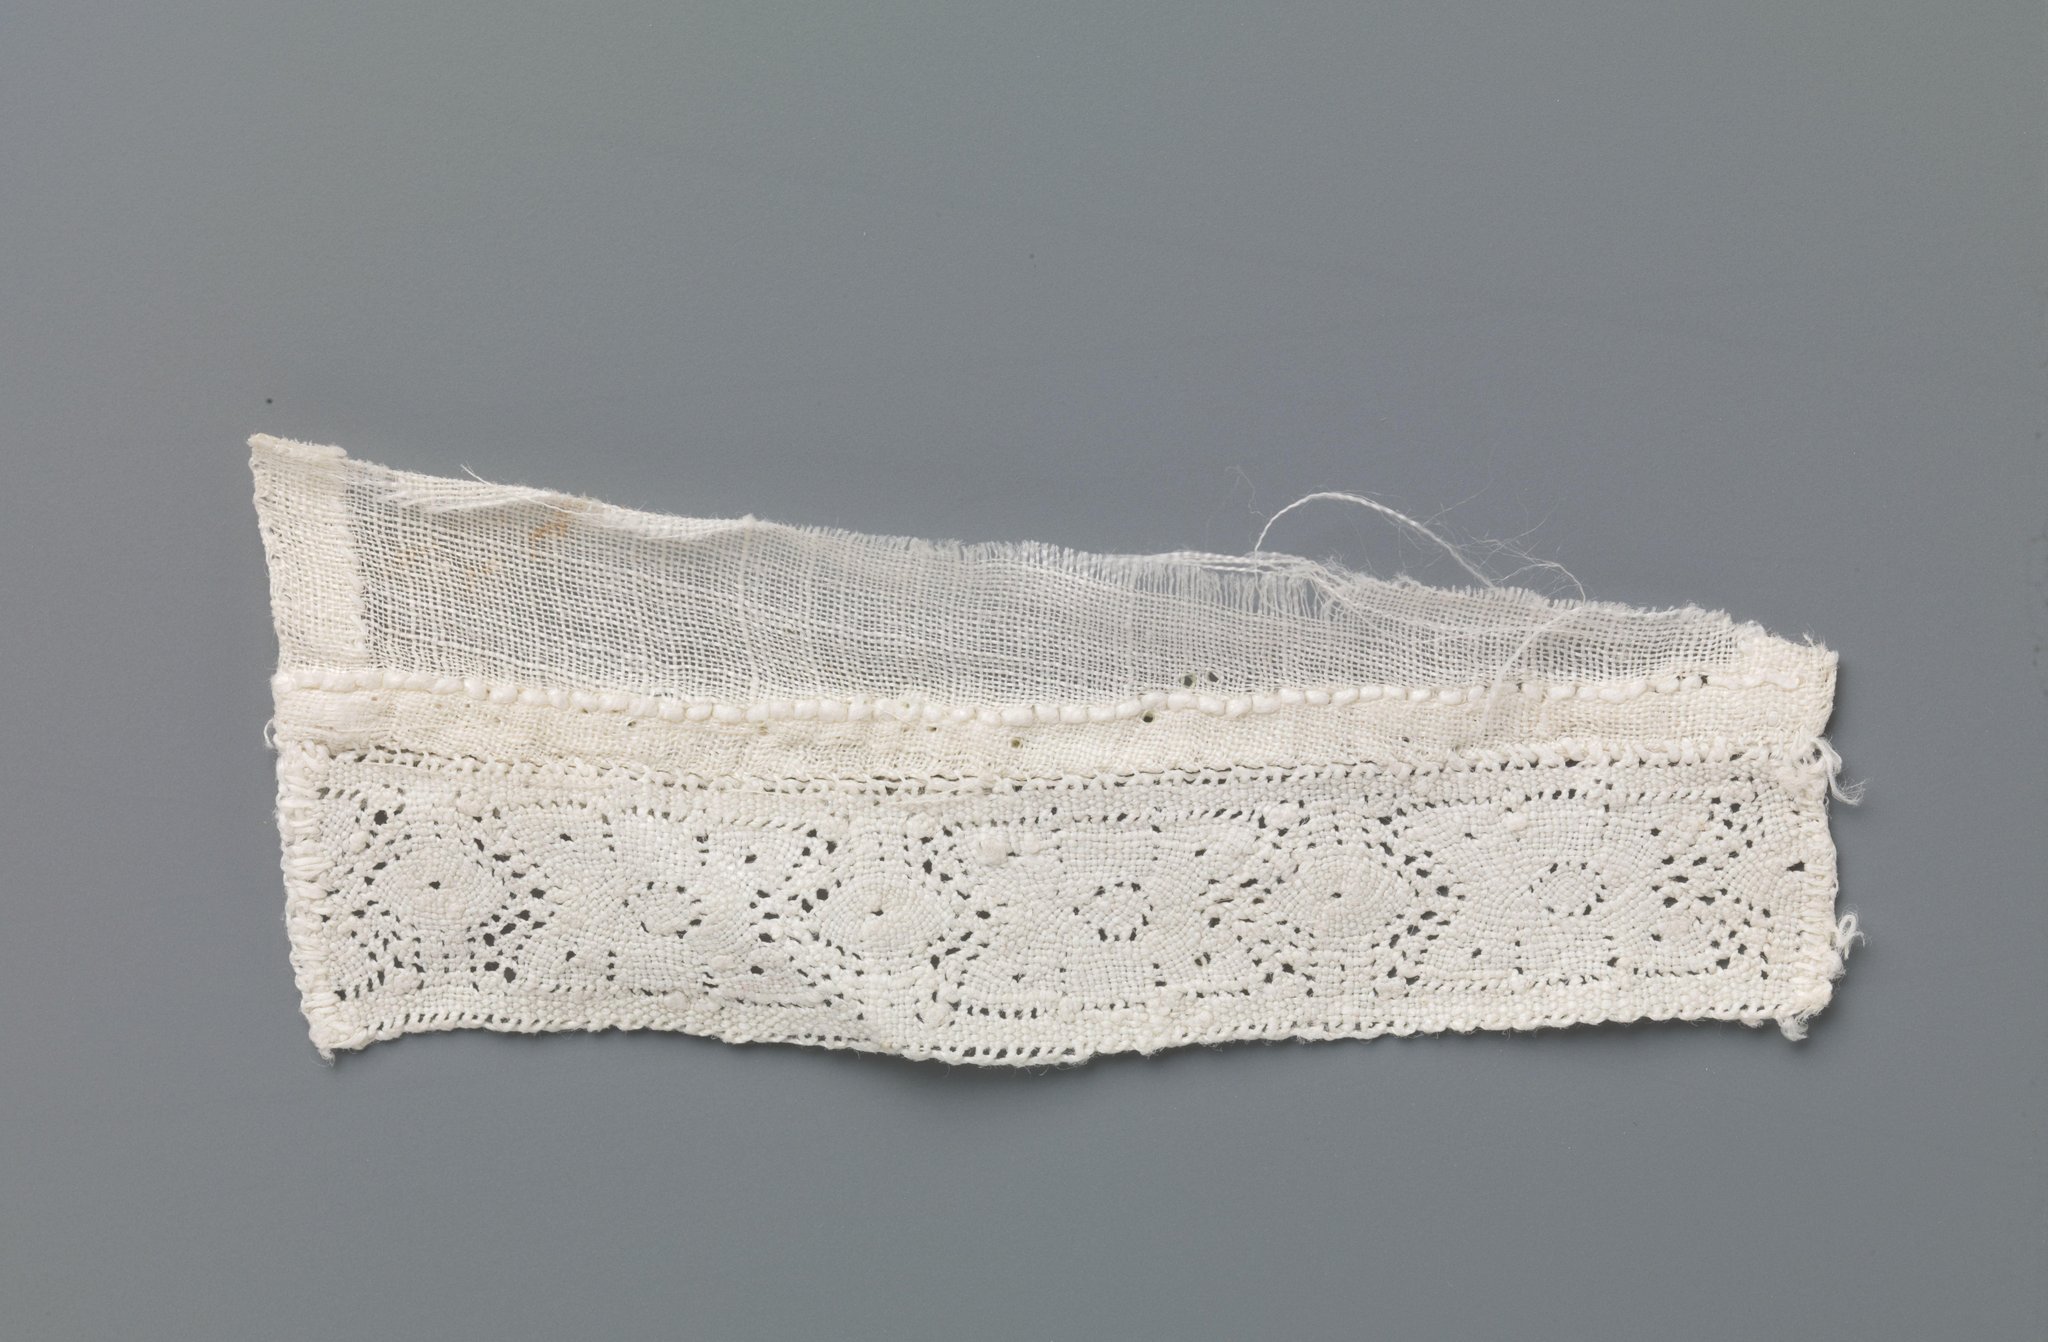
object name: strip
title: Strookje kloskant met gestileerde bloem tussen twee vertikale lijnen en ovalen aan een driehoekig fragment linnen batist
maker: Anonymous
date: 1600-1635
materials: linen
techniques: lace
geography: southern netherlands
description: Strookje naturelkleurige kloskant, oudvlaamse kant of Hollandse kloskant. Het strookje zit vast aan een driehoekig fragment linnen batist. Het kant heeft een patroon dat bestaat uit vertikale rechte lijnen, waartussen een gestileerde bloem staat. Op de middenlijn wordt de bloem links en rechts geflankeerd door een liggend spitsovaaltje, dat de vertikale lijn steeds oversnijdt. De motieven zijn gemaakt in linnenslag met uitsparingen, er is nauwelijks sprake van een grond, de motieven zijn door zeer korte vlechtjes met elkaar verbonden. Boven- en onderzijde van het strookje zijn afgewerkt met een rechte rand.